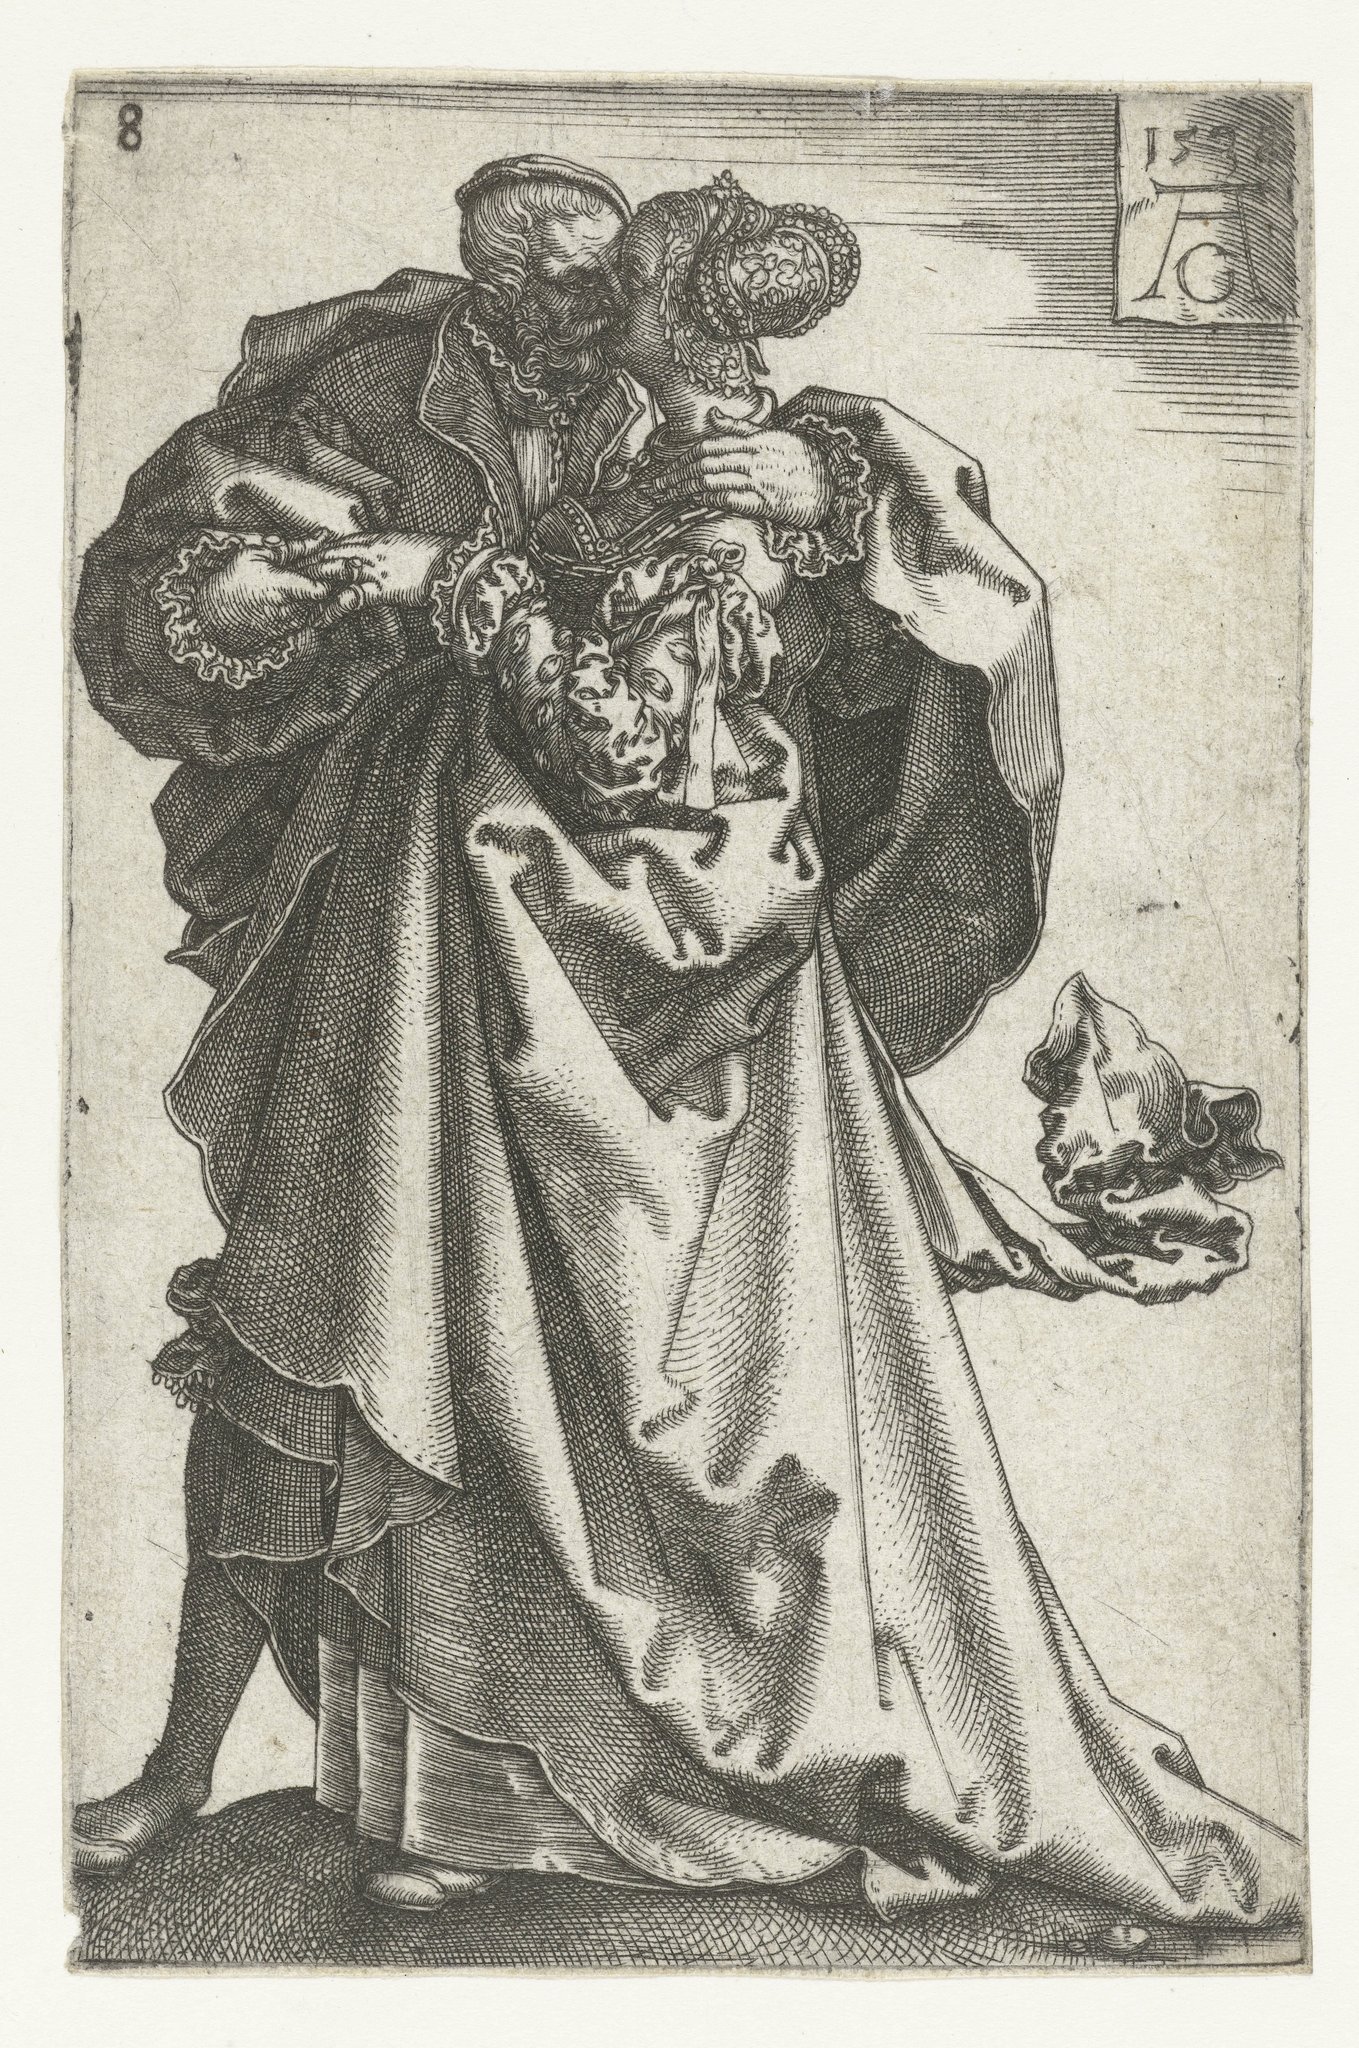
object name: print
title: Kussend paar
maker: heinrich aldegrever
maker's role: draughtsman, print maker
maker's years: 1502-1561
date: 1538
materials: paper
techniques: engraving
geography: germany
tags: (lovers) kissing each other, dancing at wedding feast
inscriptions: number: ‘95’, collector's mark: Lugt 2228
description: Man en vrouw kussend. Hij heeft zijn arm om haar schouder geslagen en houdt haar hand vast. Achtste prent uit een serie van twaalf, vrij naar het werk van Schäufelein.